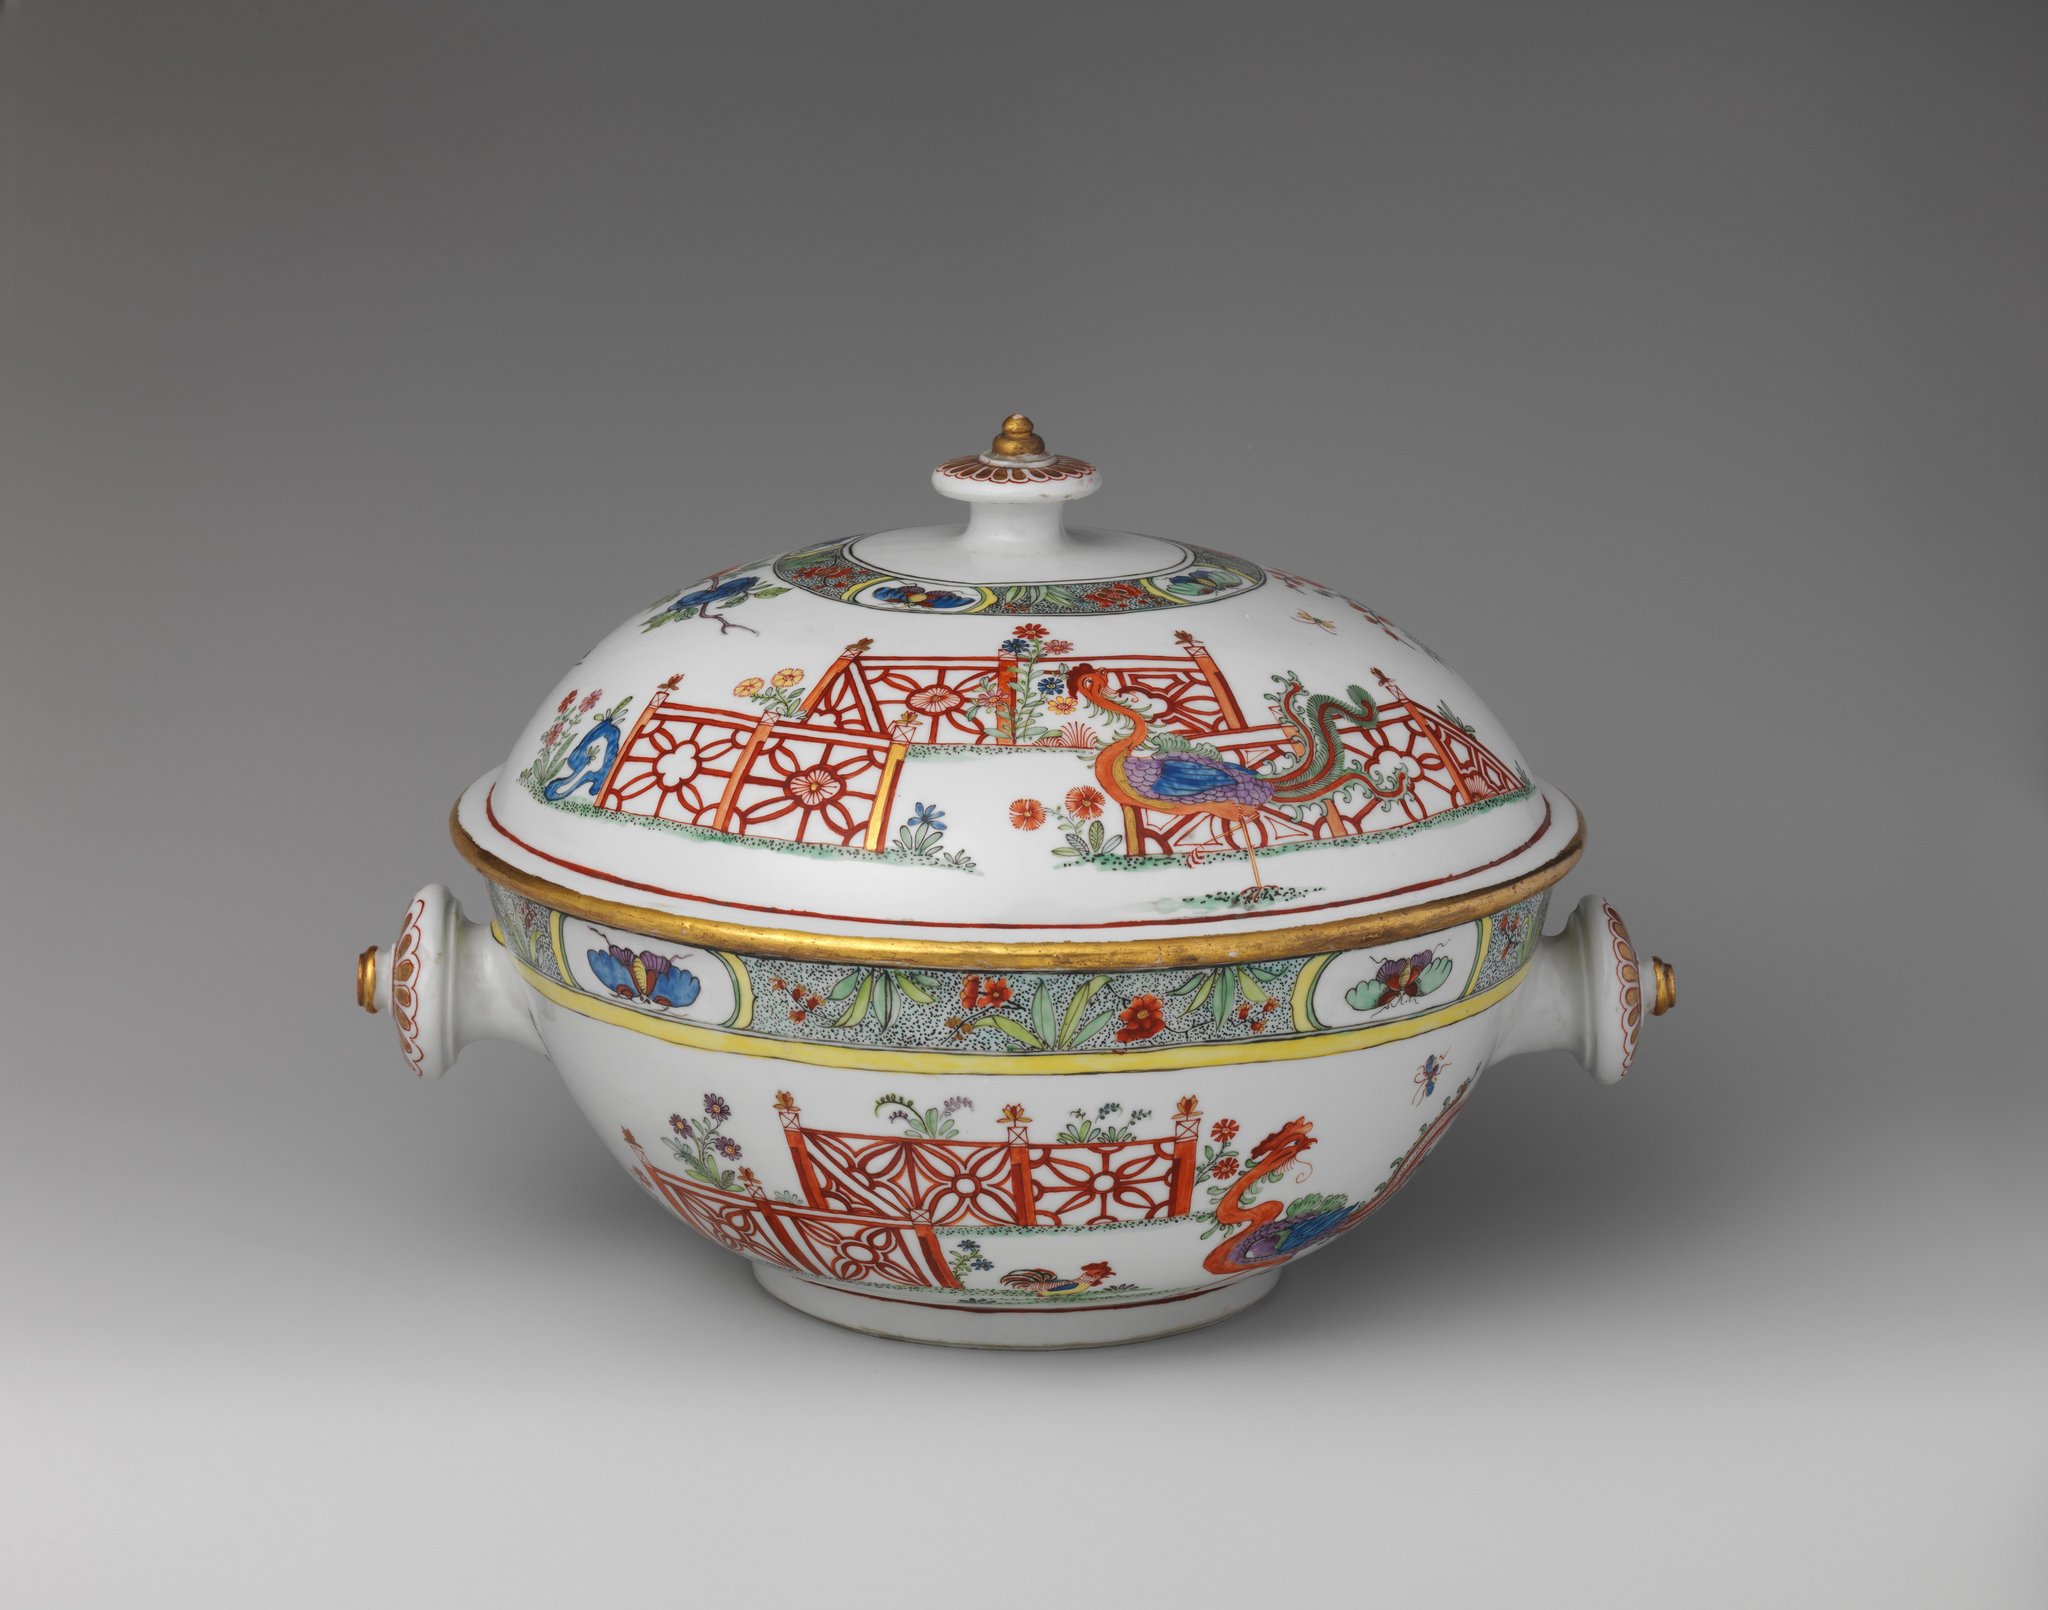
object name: tureen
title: Tureen with phoenixes in landscape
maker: vienna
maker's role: manufactory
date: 1725-1730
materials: enamel, glaze, hard paste porcelain, porcelain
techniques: painting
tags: phoenix,insects